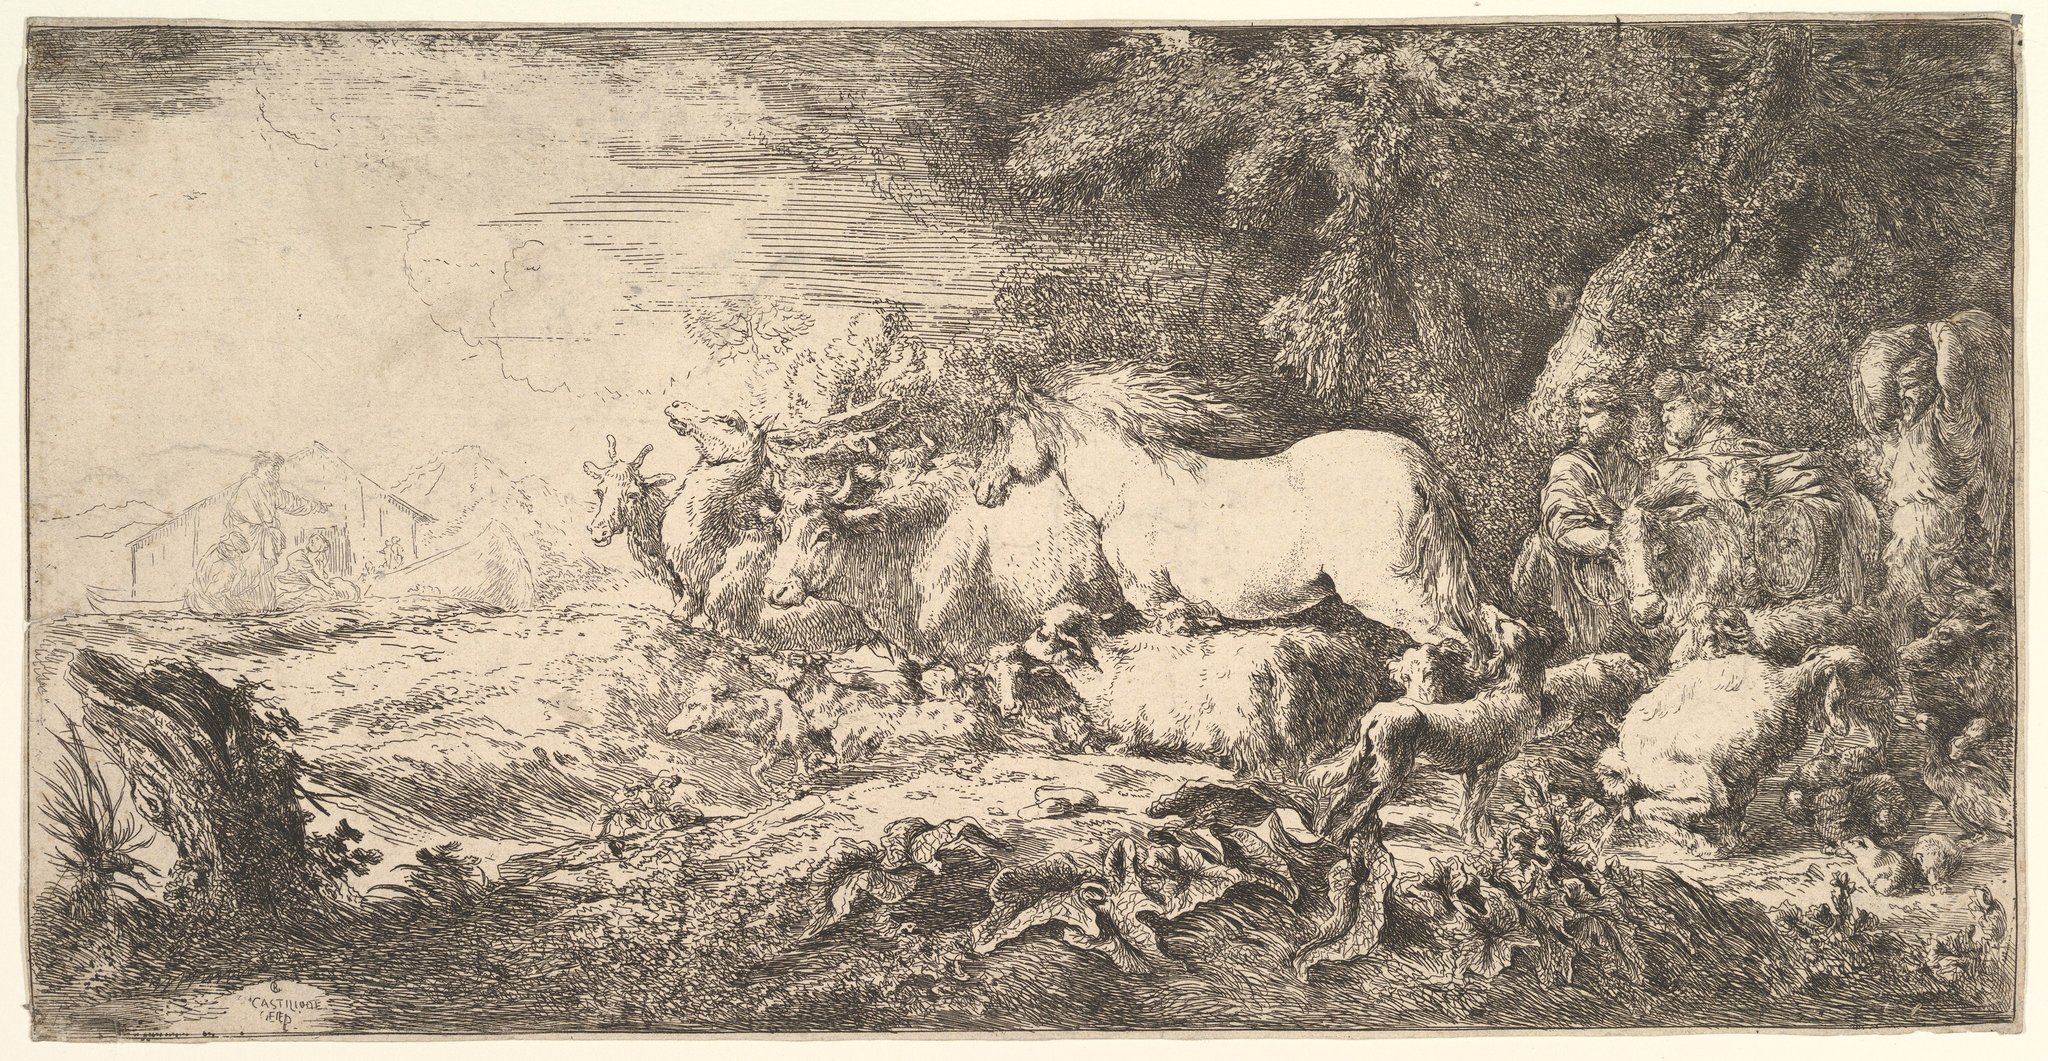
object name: print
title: Entry of the animals into Noah's ark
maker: giovanni benedetto castiglione (il grechetto)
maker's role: artist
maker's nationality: italian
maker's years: 1609-1664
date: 1650-1655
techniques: etching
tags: men,cows,dogs,horses,sheep